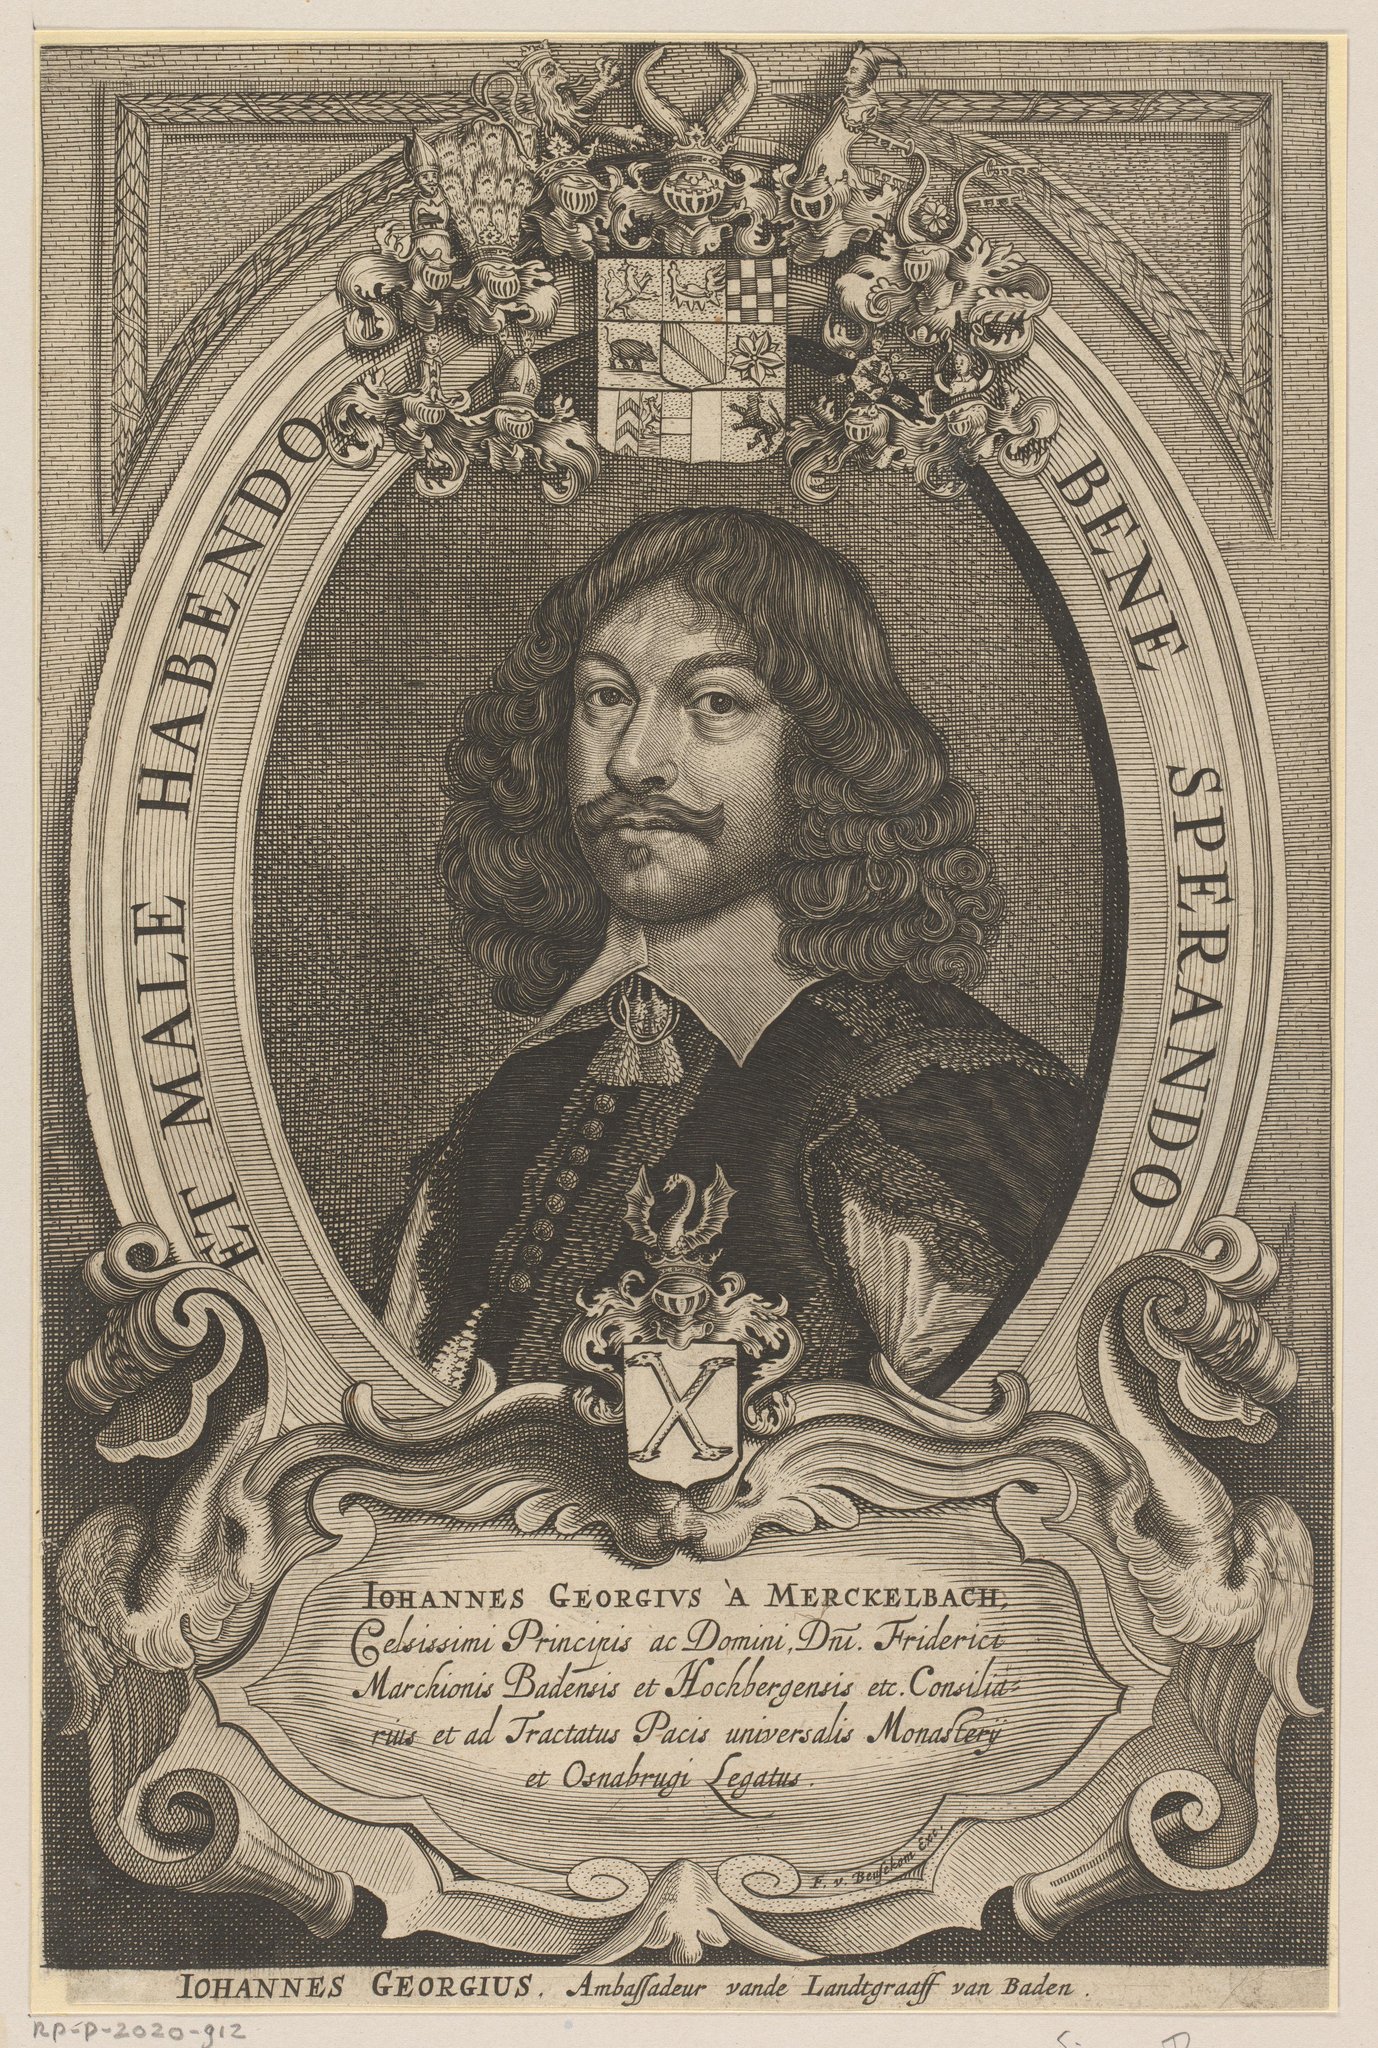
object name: print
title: Iohannes Georgius, ambassadeur vande landtgraaff van Baden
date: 1648-1665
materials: paper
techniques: engraving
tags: official; civil servant; functionary (in general), historical persons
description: Kopie naar een prent van Mattheus Borrekens. Zie documentatie. De prent maakt waarschijnlijk onderdeel uit van een serie portretten met vredesonderhandelaars die betrokken waren bij de Vrede van Münster.